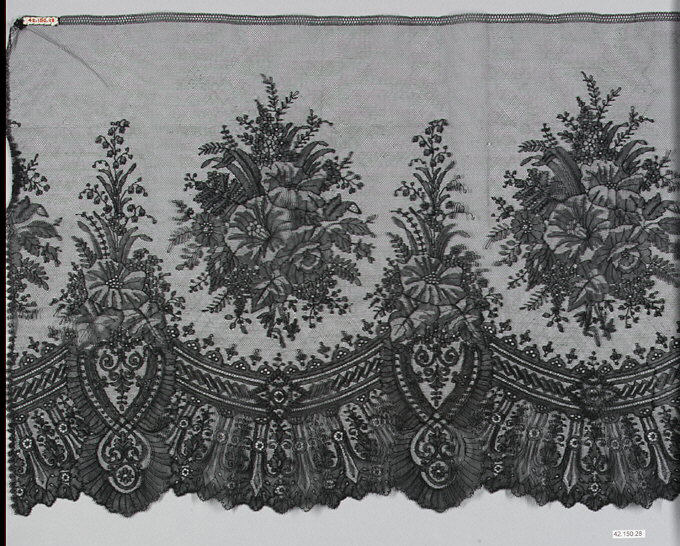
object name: flounce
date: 1801-1900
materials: silk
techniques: lace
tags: flowers